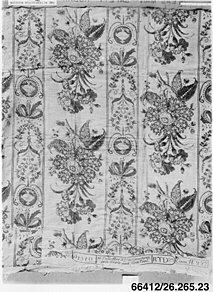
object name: floral print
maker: j. p. meillier & cie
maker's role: manufactory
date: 1790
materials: linen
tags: flowers,leaves